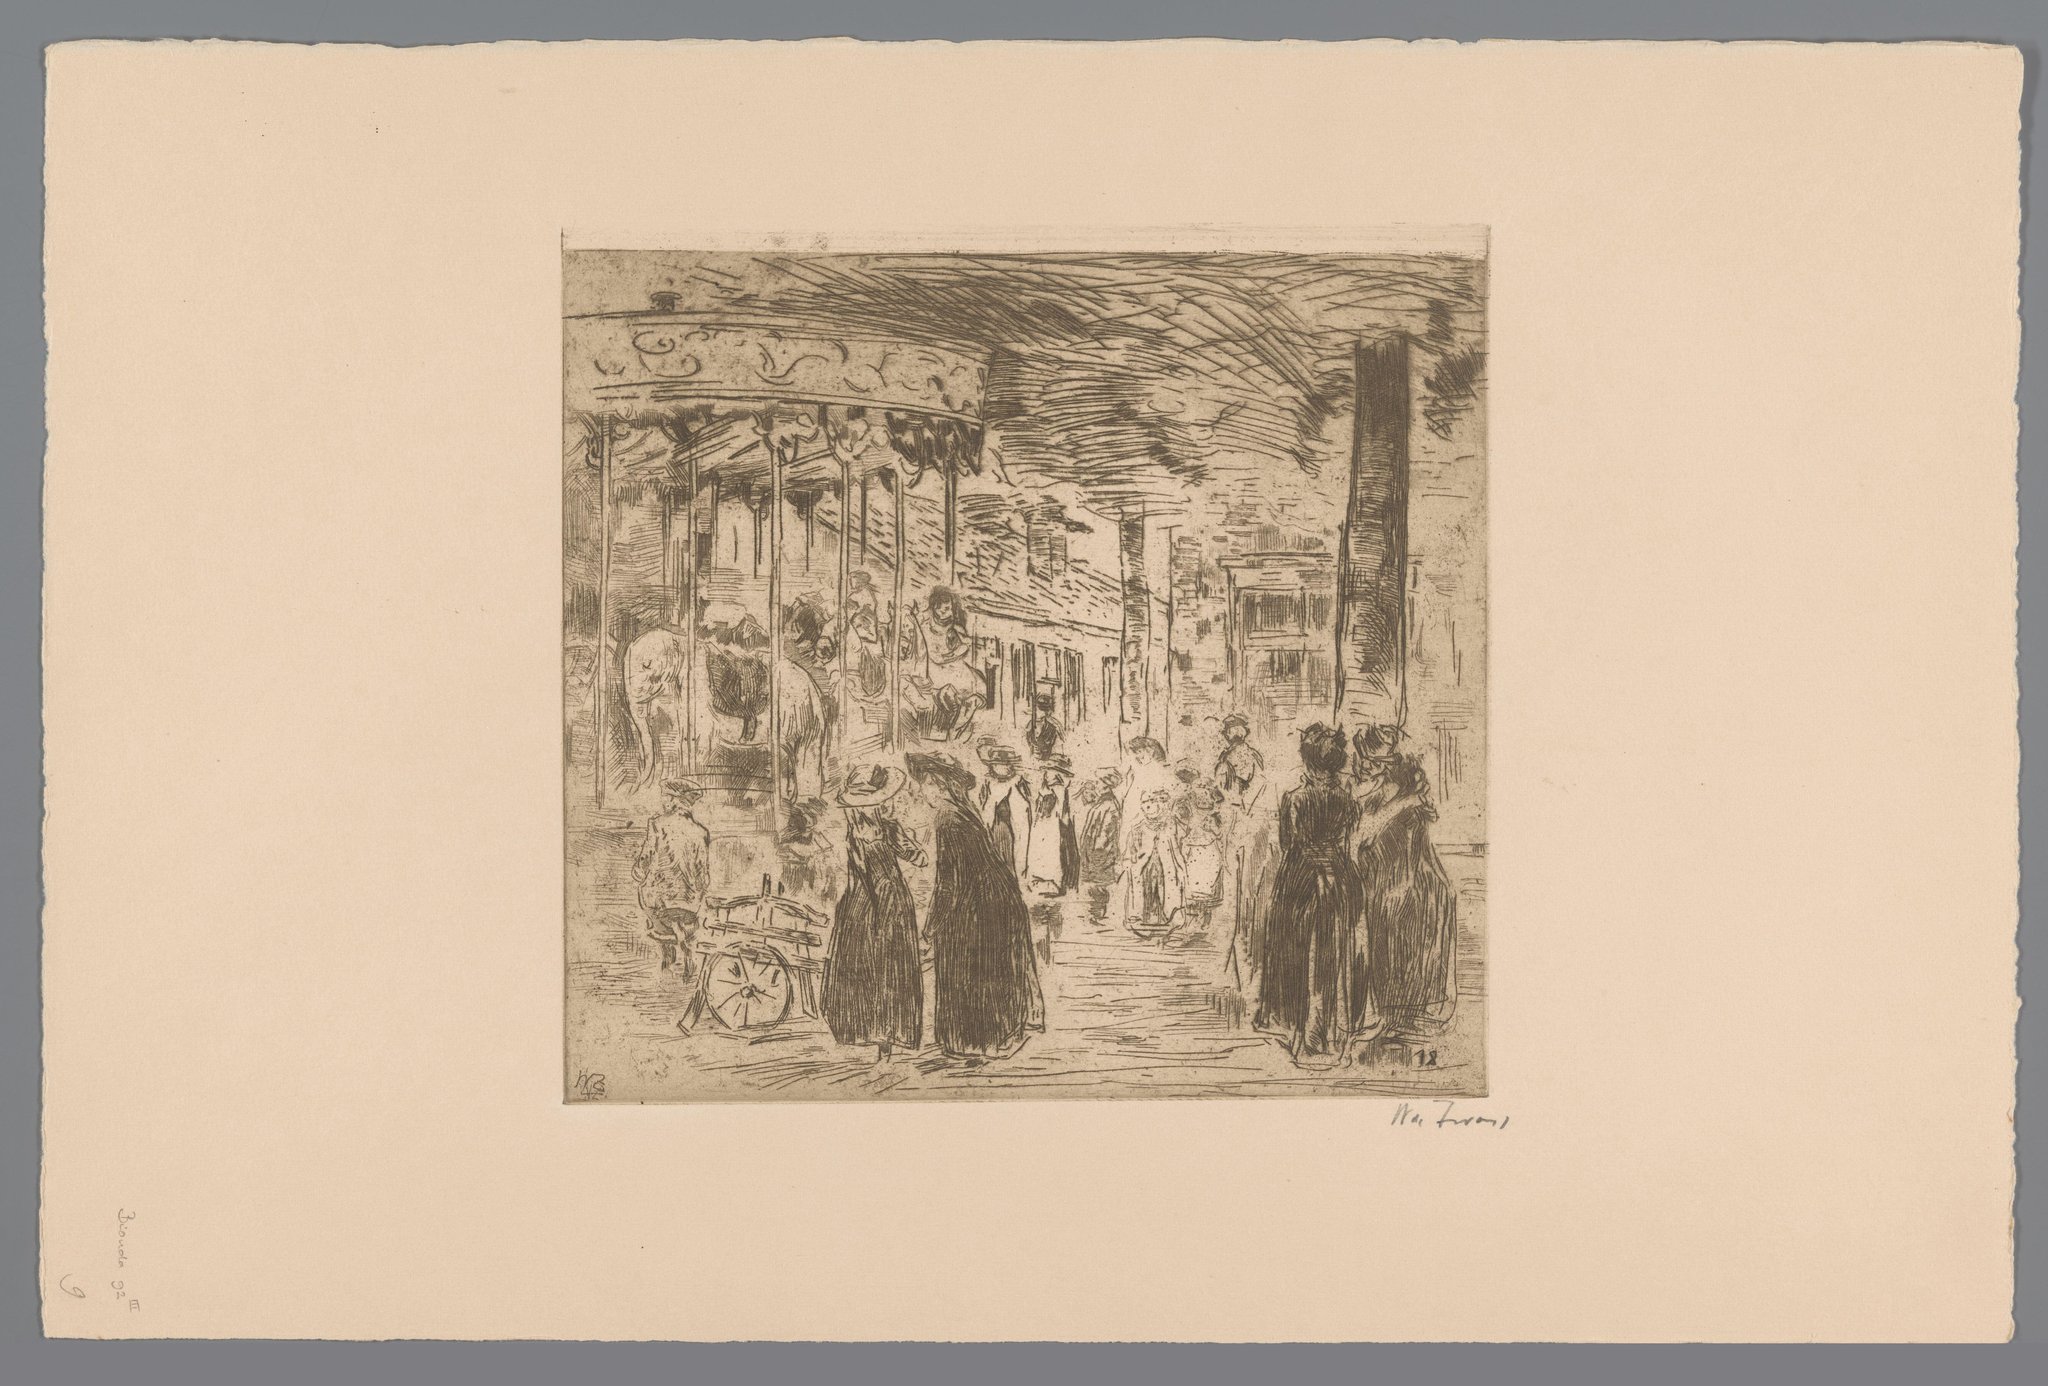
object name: print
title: Draaimolen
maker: willem de zwart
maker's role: draughtsman, painter, print maker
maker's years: 1862-1931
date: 1924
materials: paper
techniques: drypoint, etching, intaglio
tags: merry-go-round, roundabout; chair o'plane, pleasure fair and circus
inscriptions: collector's mark: Lugt 2760, collector's mark: Lugt 2228